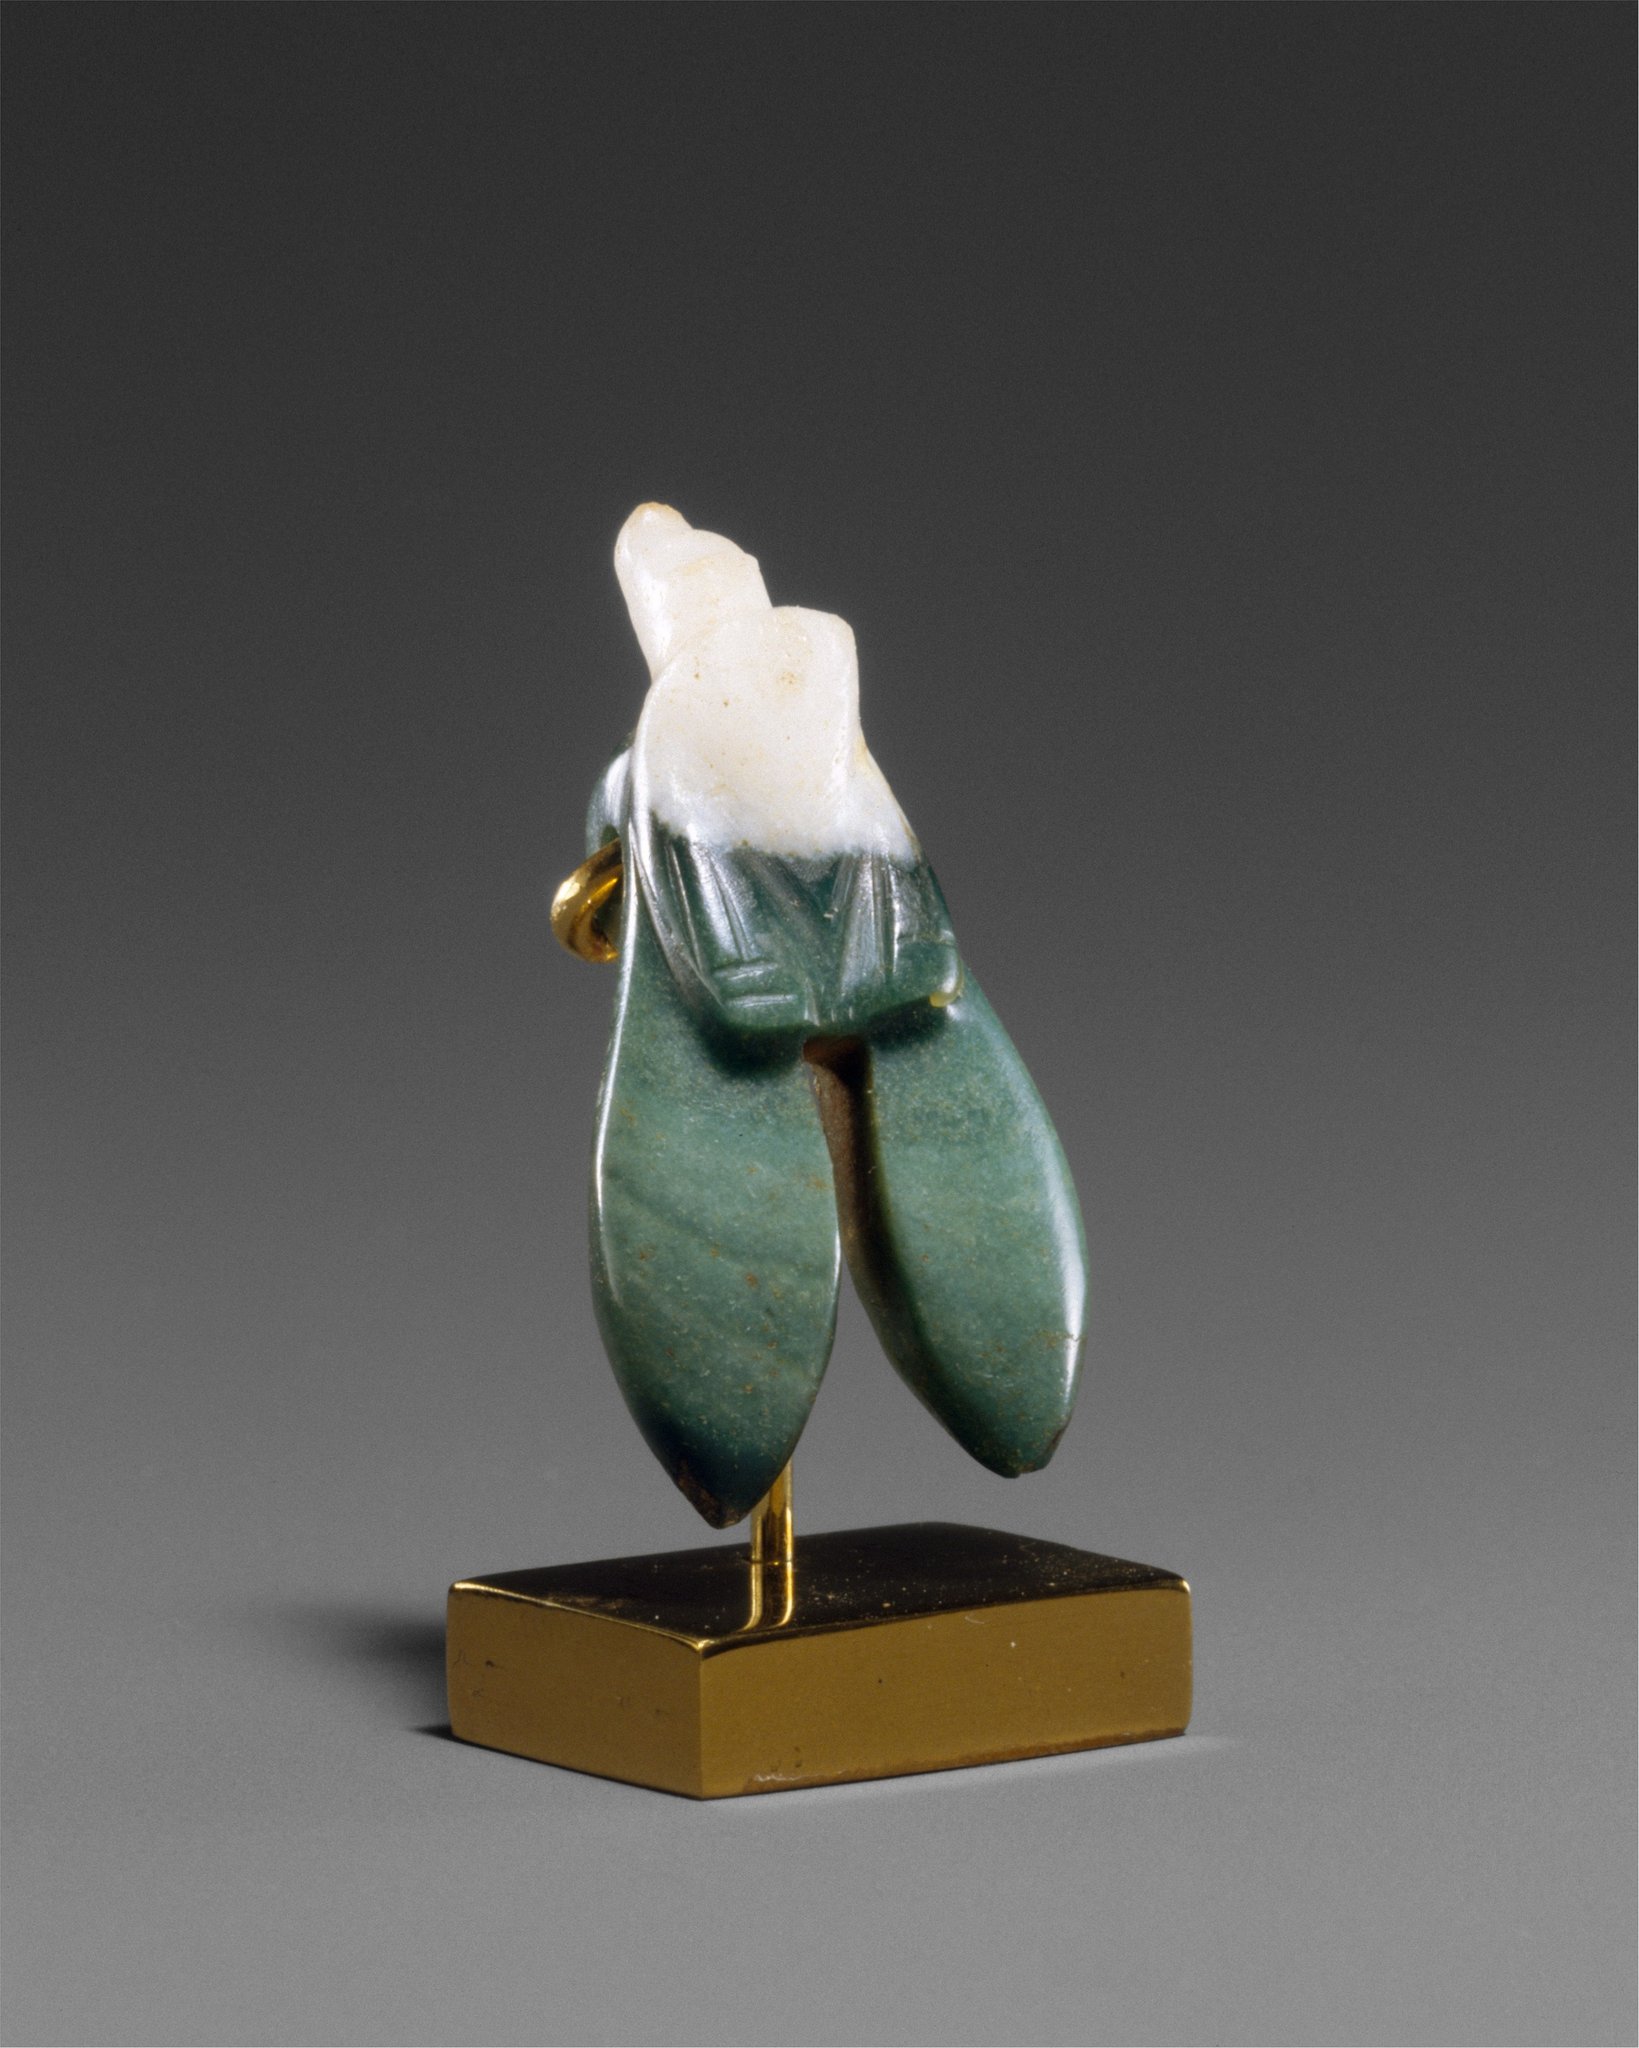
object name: amulet, mosquito deity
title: Mosquito Deity amulet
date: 712-332 BCE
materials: jasper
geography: egypt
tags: insects